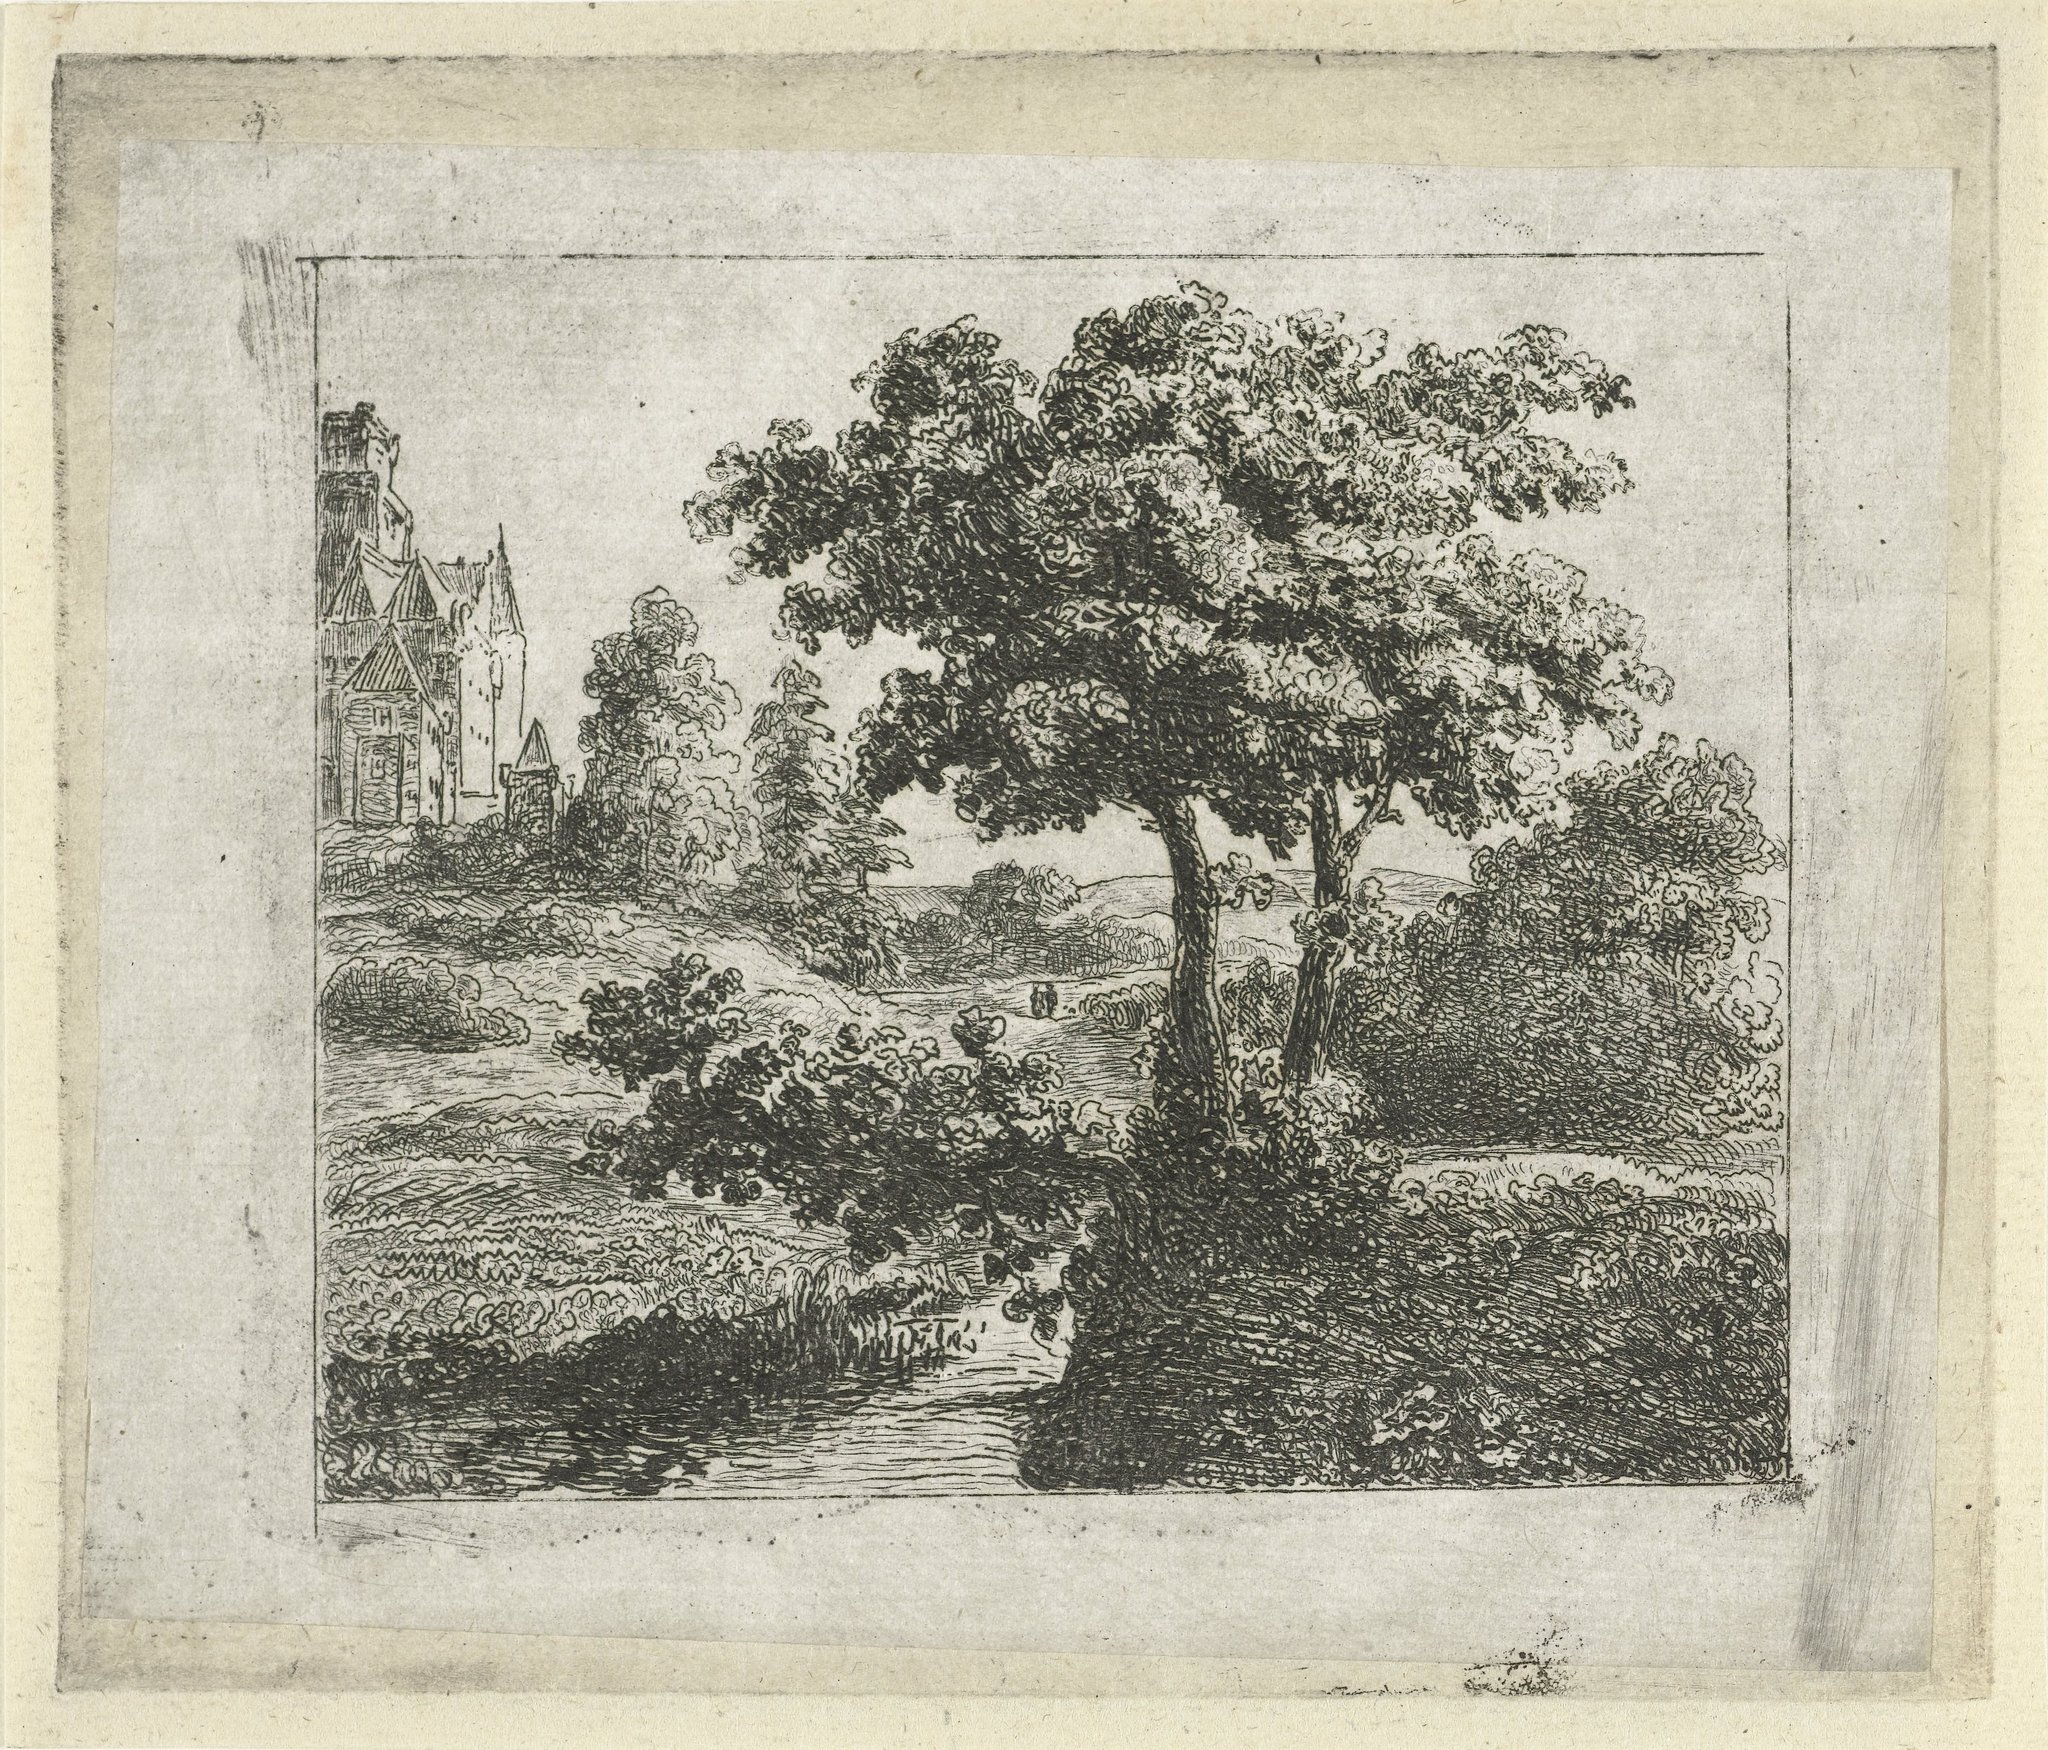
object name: print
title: Landschap met kerk op een heuvel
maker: johannes adrianus van der drift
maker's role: print maker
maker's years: 1808-1883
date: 1823-1883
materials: paper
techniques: etching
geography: netherlands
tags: landscape with other man-made constructions not mentioned above, e.g.: graveyards, playgrounds, etc.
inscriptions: collector's mark: Lugt 2228